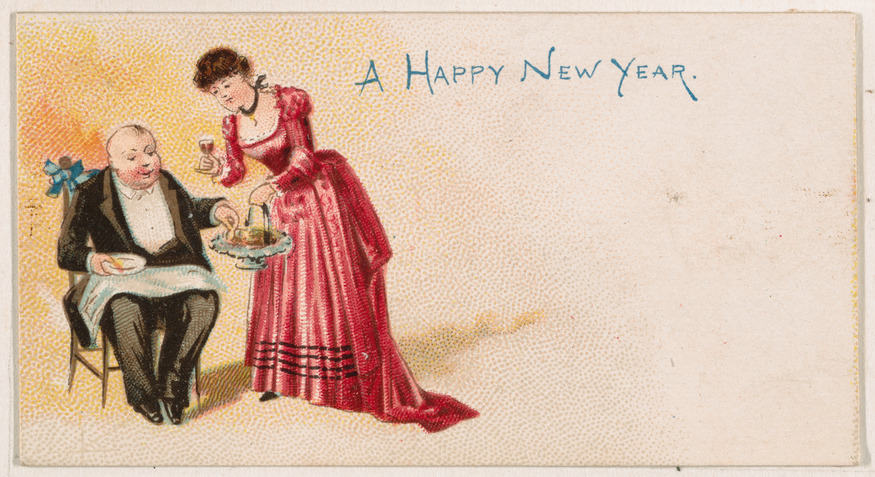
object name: print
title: A Happy New Year, from the New Years 1890 series (N227) issued by Kinney Bros.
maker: kinney brothers tobacco company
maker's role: publisher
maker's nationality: american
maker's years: 1869-2011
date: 1889-1890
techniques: color lithograph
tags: food,men,women,drinking